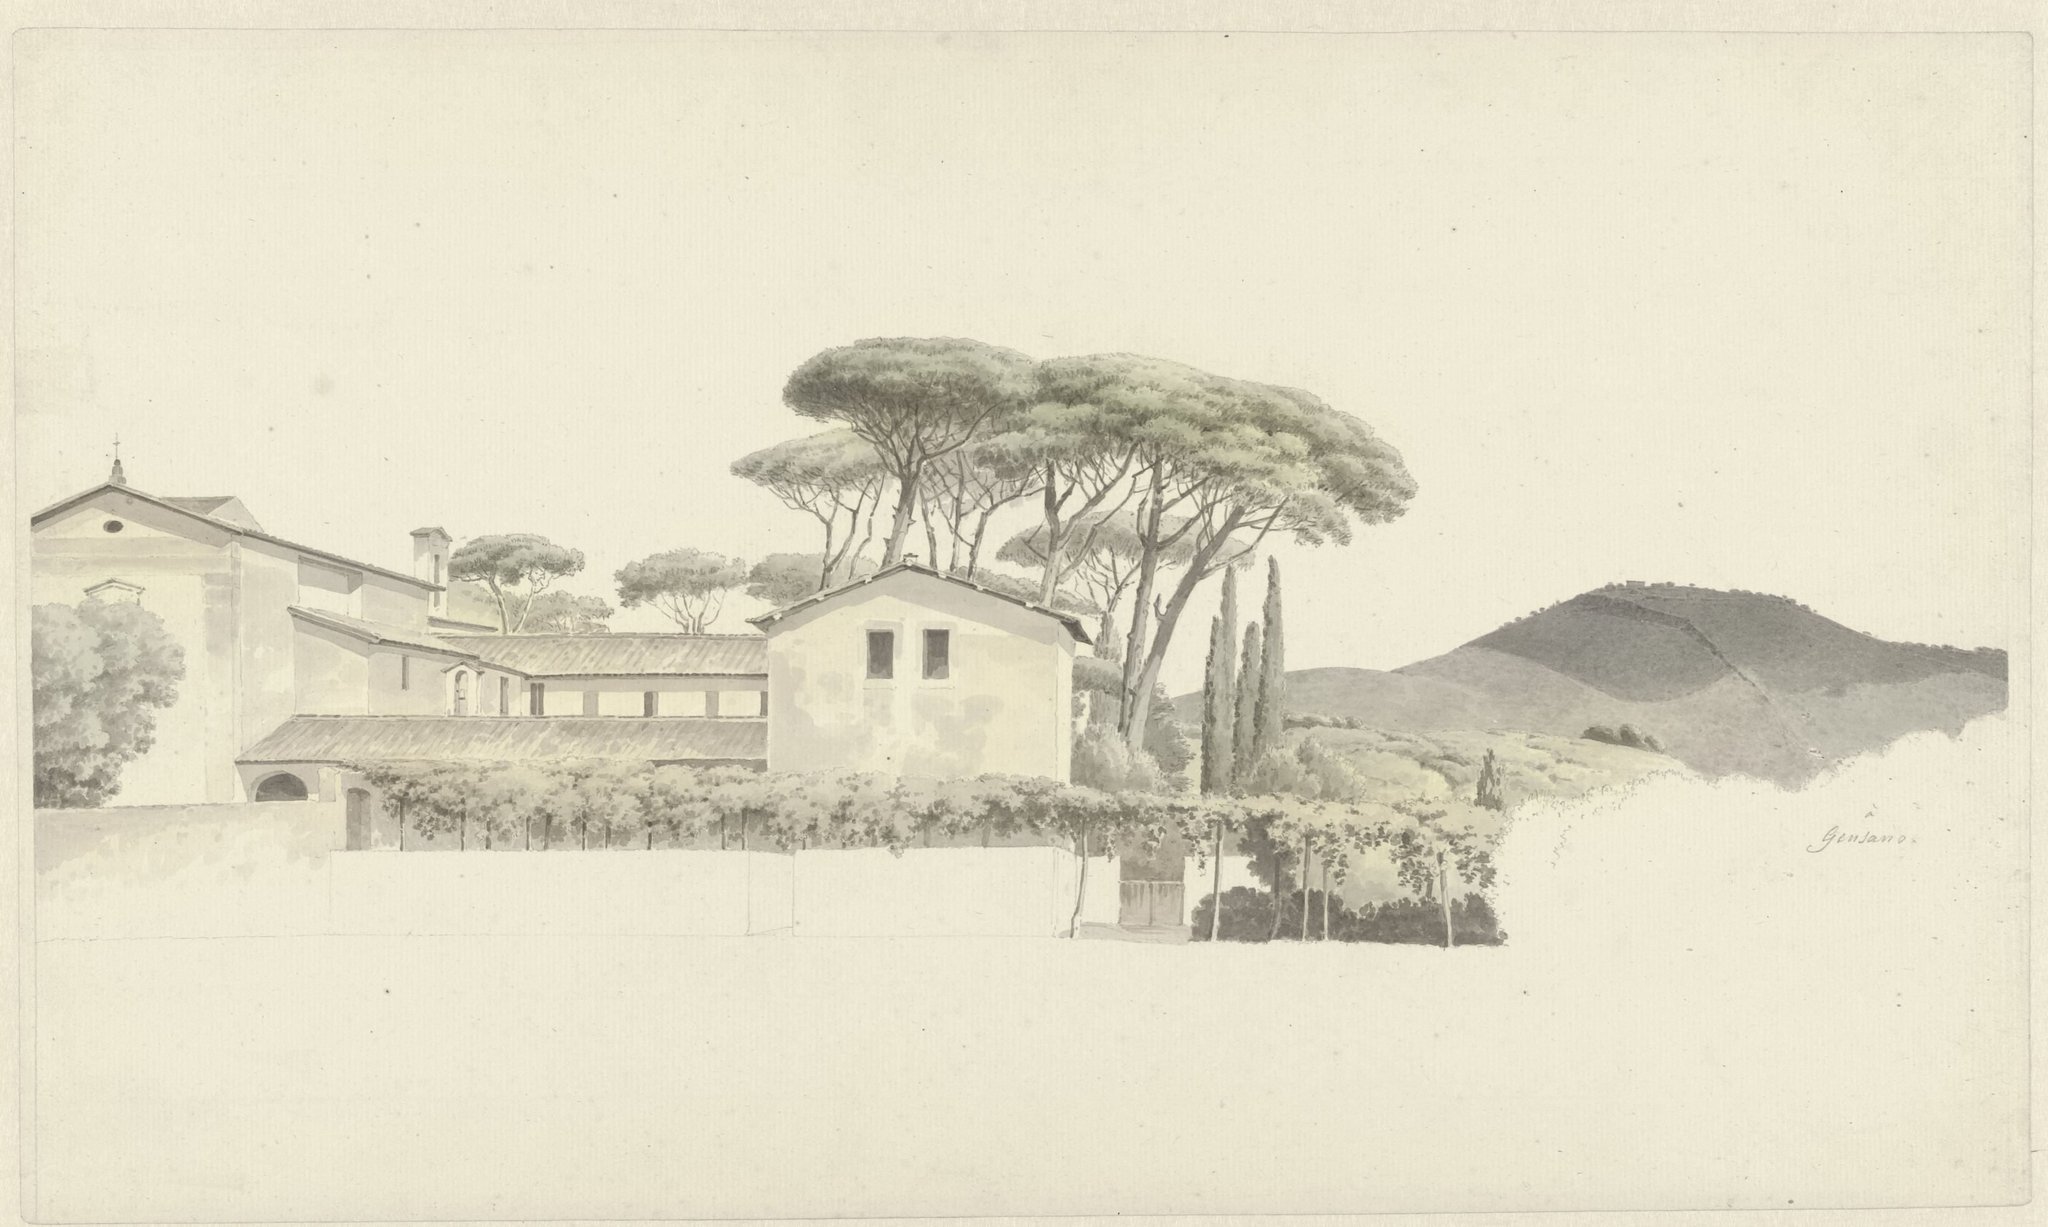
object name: drawing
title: In the Environs of Genzano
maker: josephus augustus knip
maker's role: draughtsman, painter, print maker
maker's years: 1777-1847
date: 1809-1812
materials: graphite, paper, watercolor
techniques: brush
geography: italy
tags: villa, italy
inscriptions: inscription: ‘à Gensano’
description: Just like many other artists, Knip fled from the oppressive heat in the Eternal City in the summer months and sought relief in the cooler hills east of Rome. Here he portrayed the surroundings of Genzano, a little town near Lake Nemi. Knip’s inscription on the drawing does not tell us precisely what he drew, possibly a monastery with buildings around a courtyard, and a church at the left.